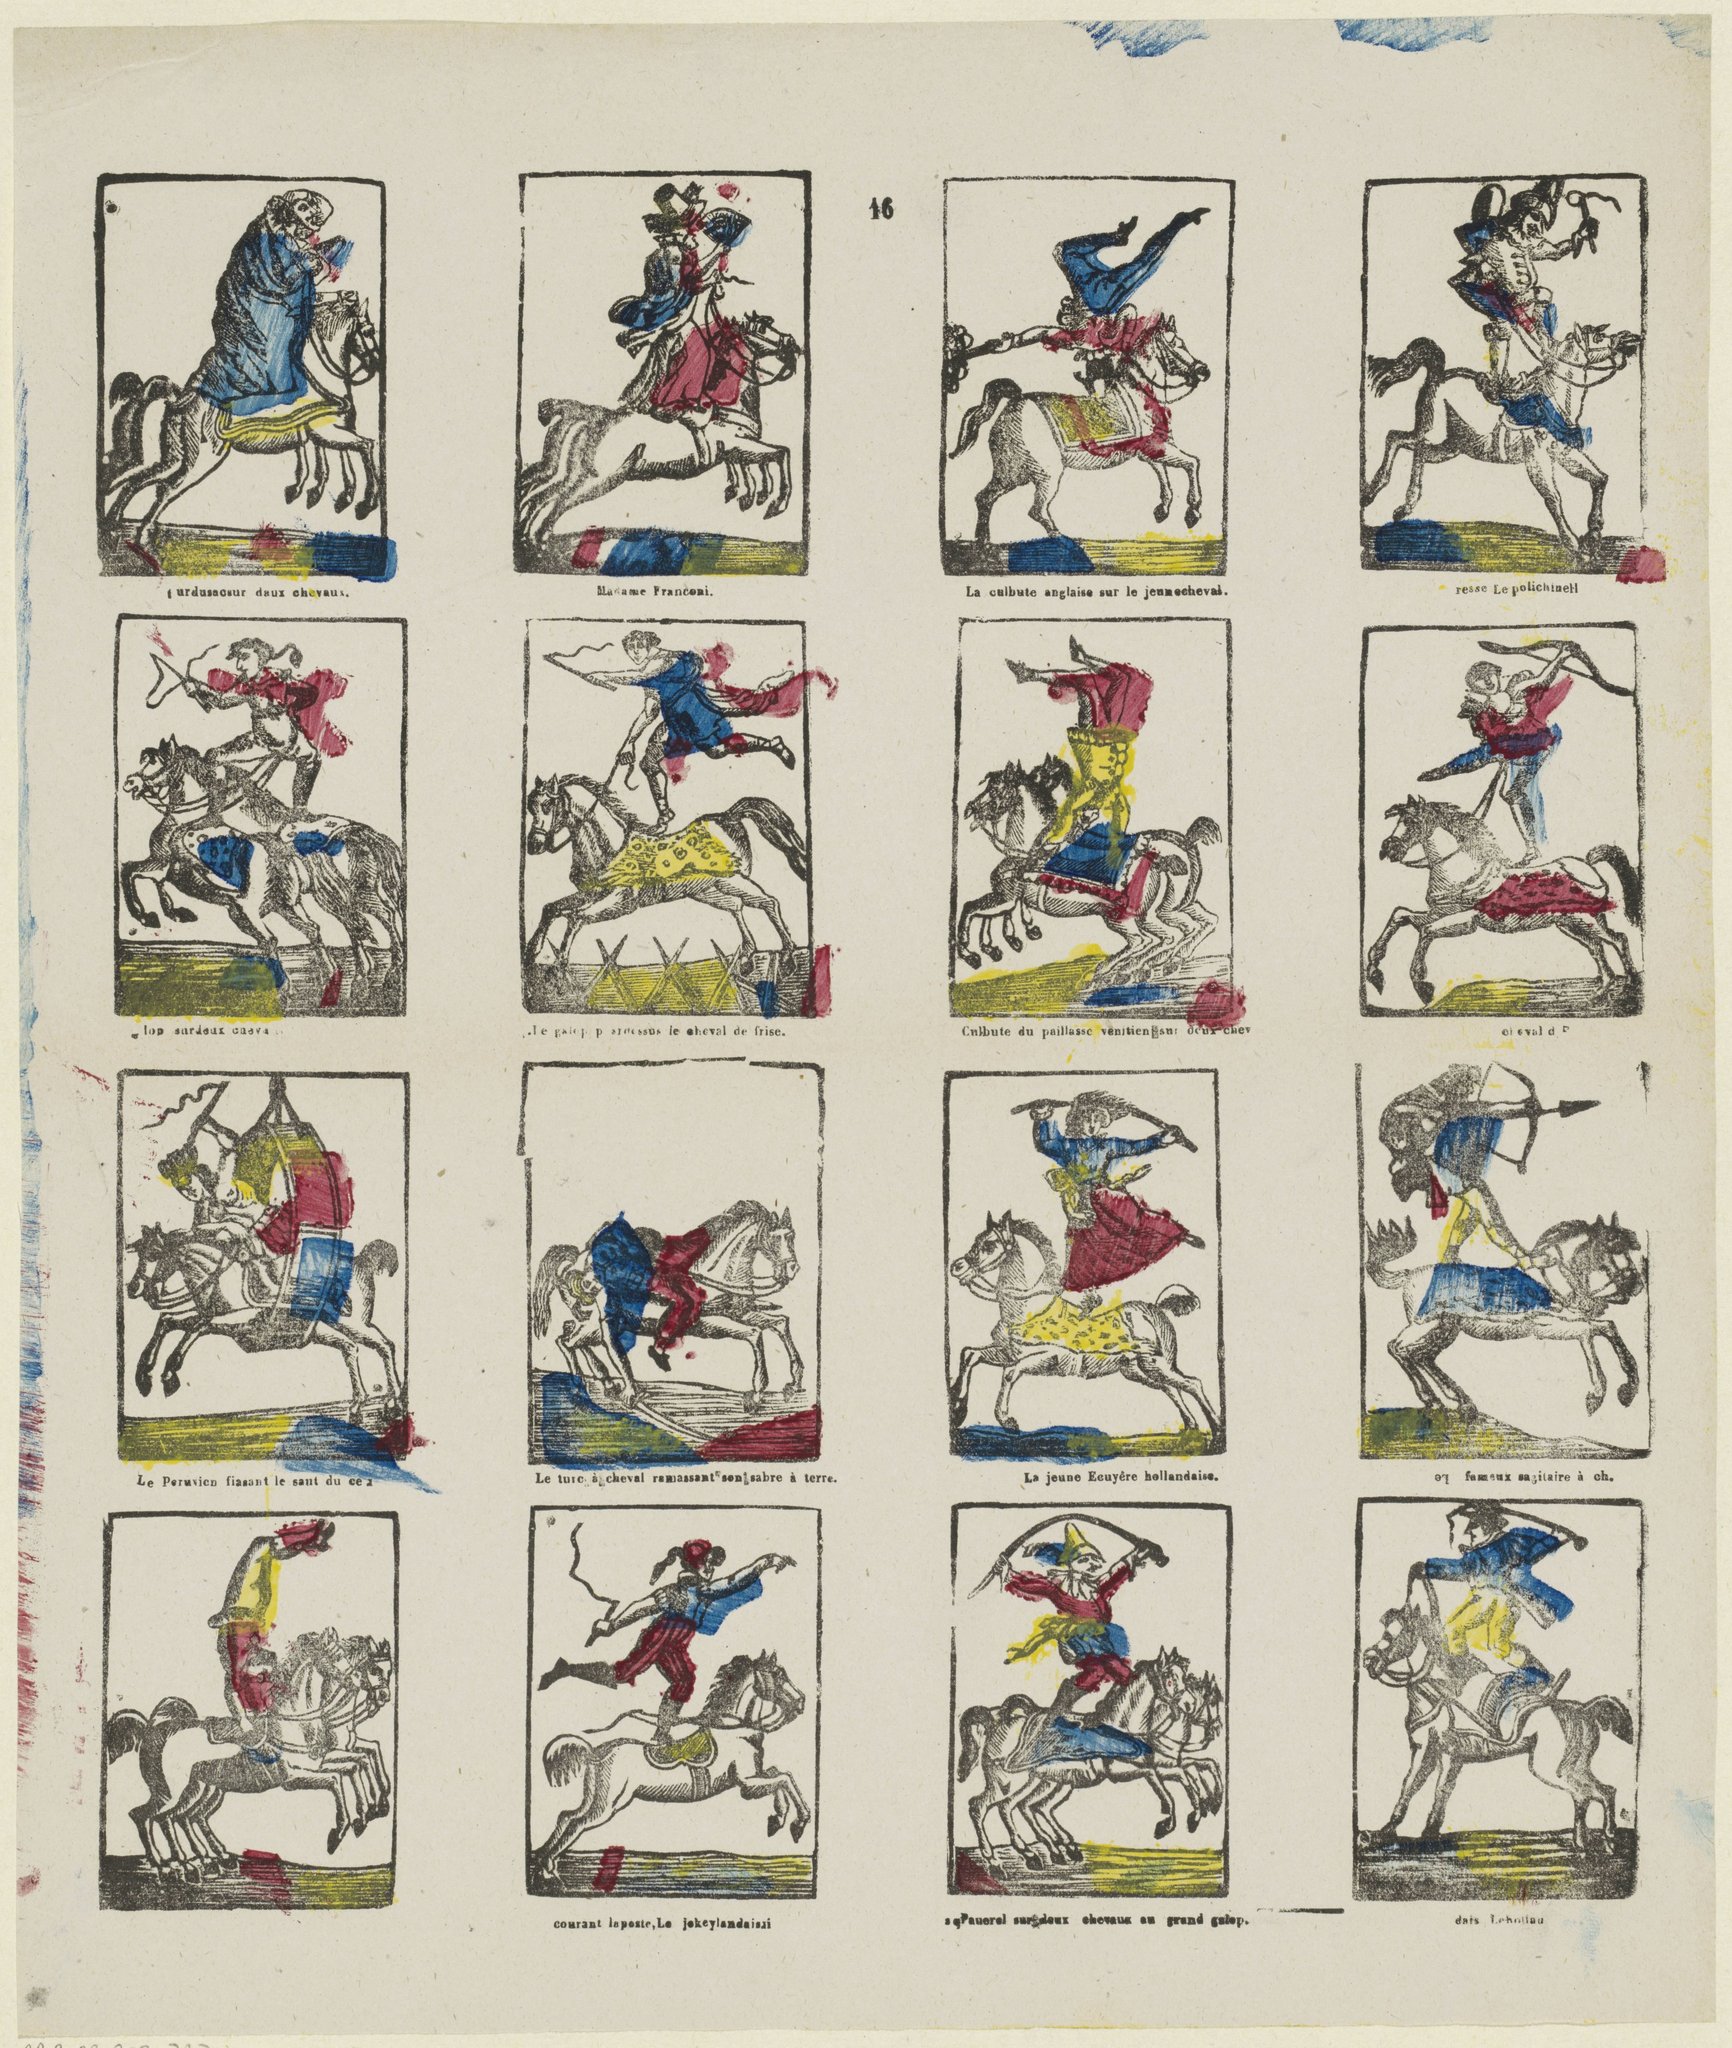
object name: popular print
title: Acrobaten te paard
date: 1827-1894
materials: paper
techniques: colour, letterpress printing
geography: schaarbeek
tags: horses (circus performance)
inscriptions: collector's mark: Lugt 2760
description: Blad met 16 voorstellingen van acrobaten die verschillende kunsten op een paard uitvoeren. Onder elke afbeelding een onderschrift in het Frans. Genummerd midden boven: 16.